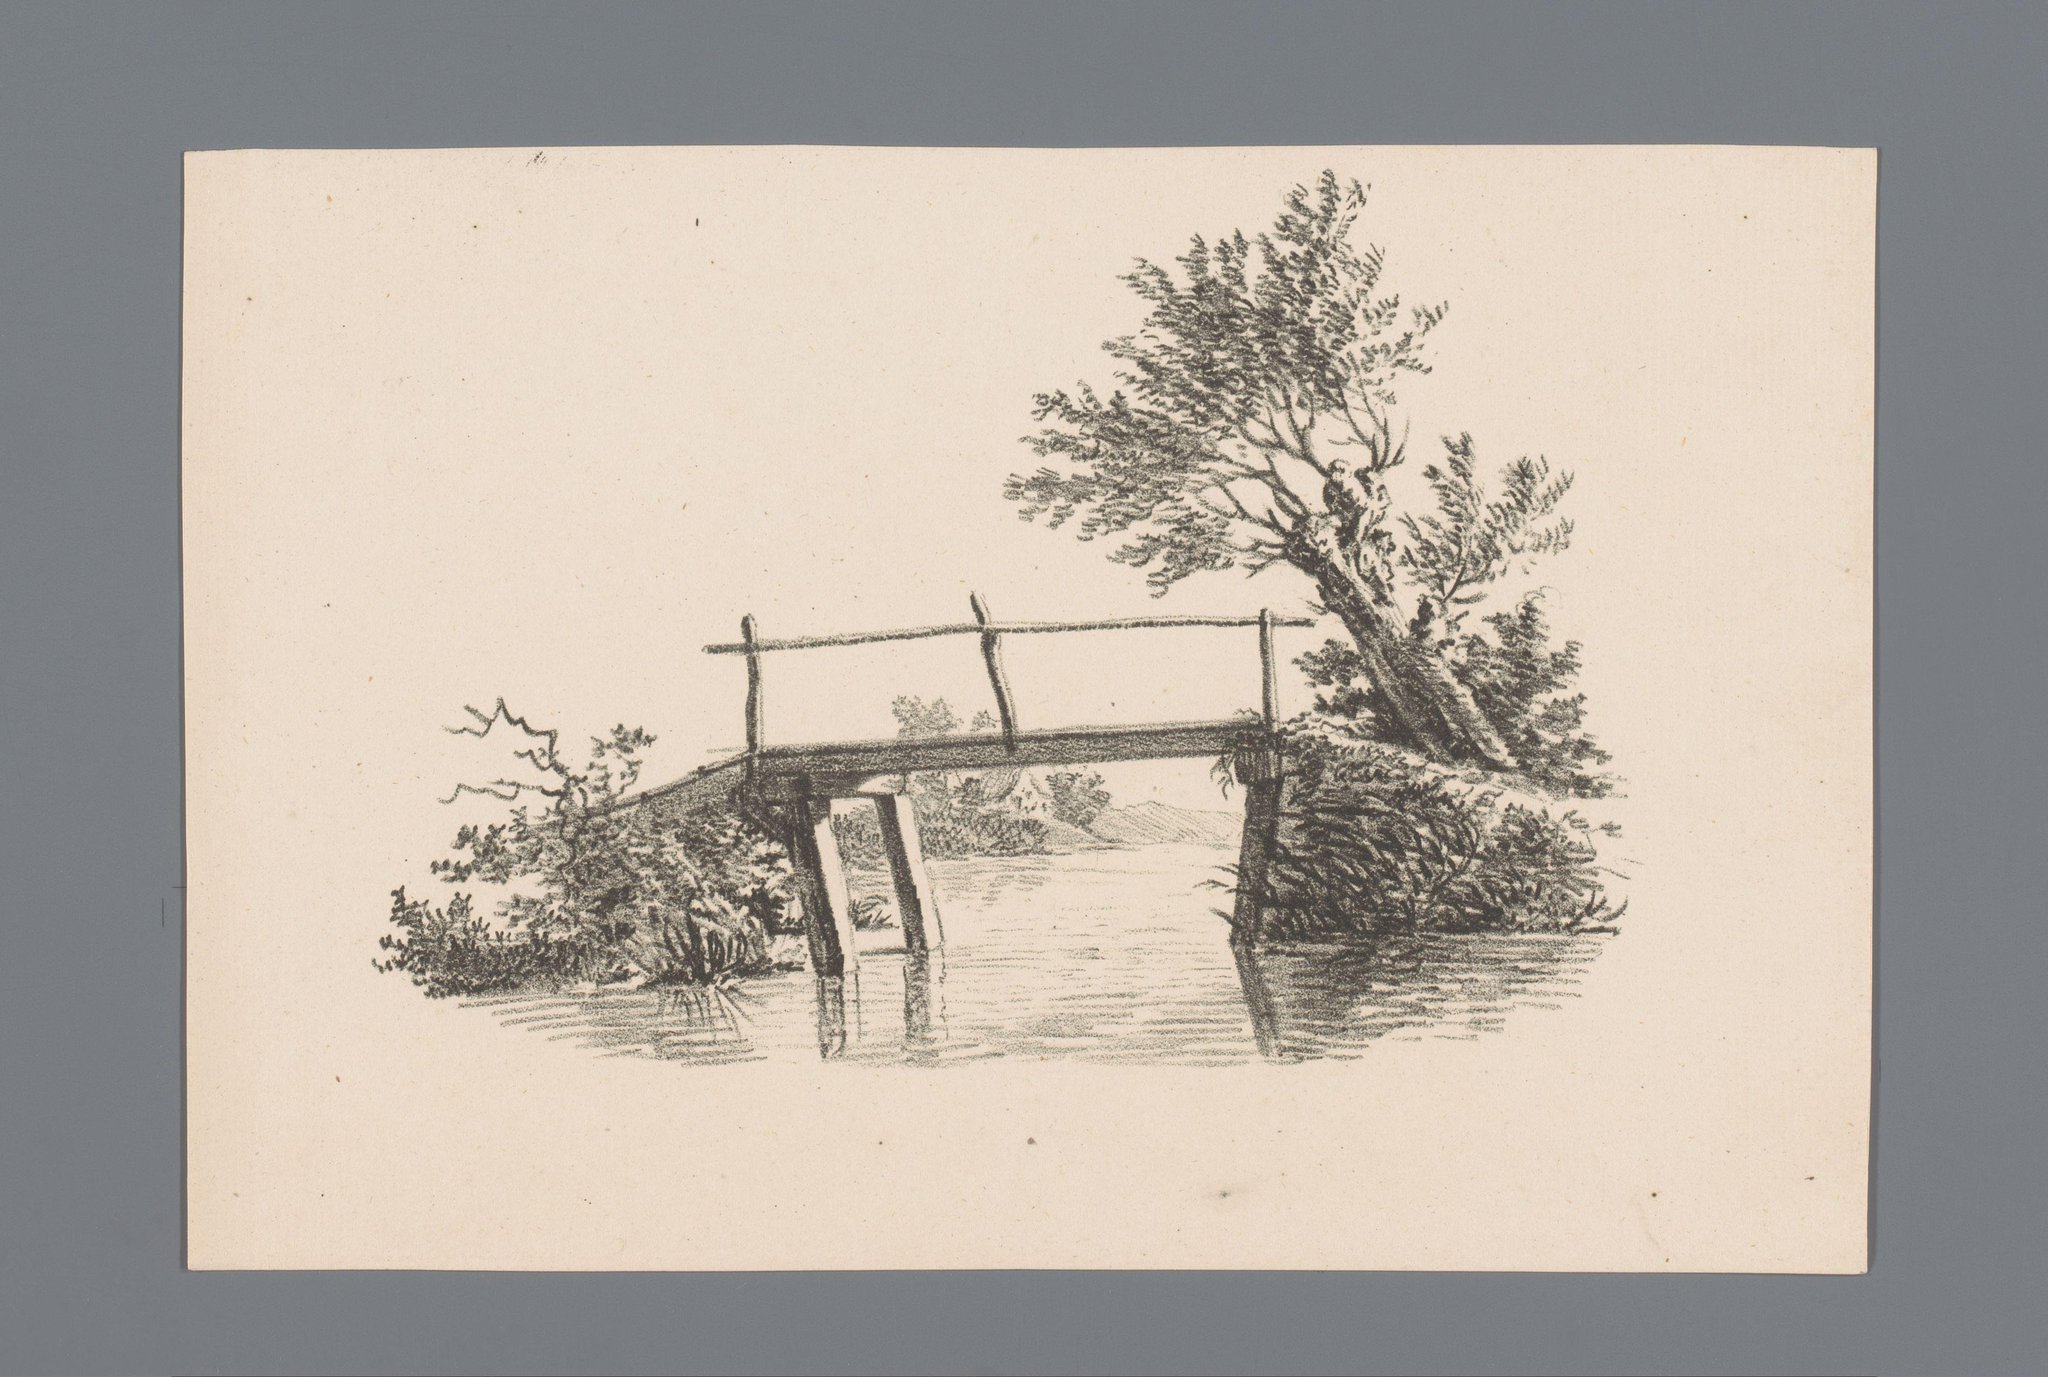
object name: print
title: Brug en een knotwilg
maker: cornelis de kruyff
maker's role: draughtsman, print maker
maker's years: 1774-1828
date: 1809-1854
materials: paper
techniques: lithograph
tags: trees: willow, bridge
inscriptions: collector's mark: Lugt 2228, watermark: ‘Bijenkorf’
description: Maakt deel uit van een omslag met dertien prenten.